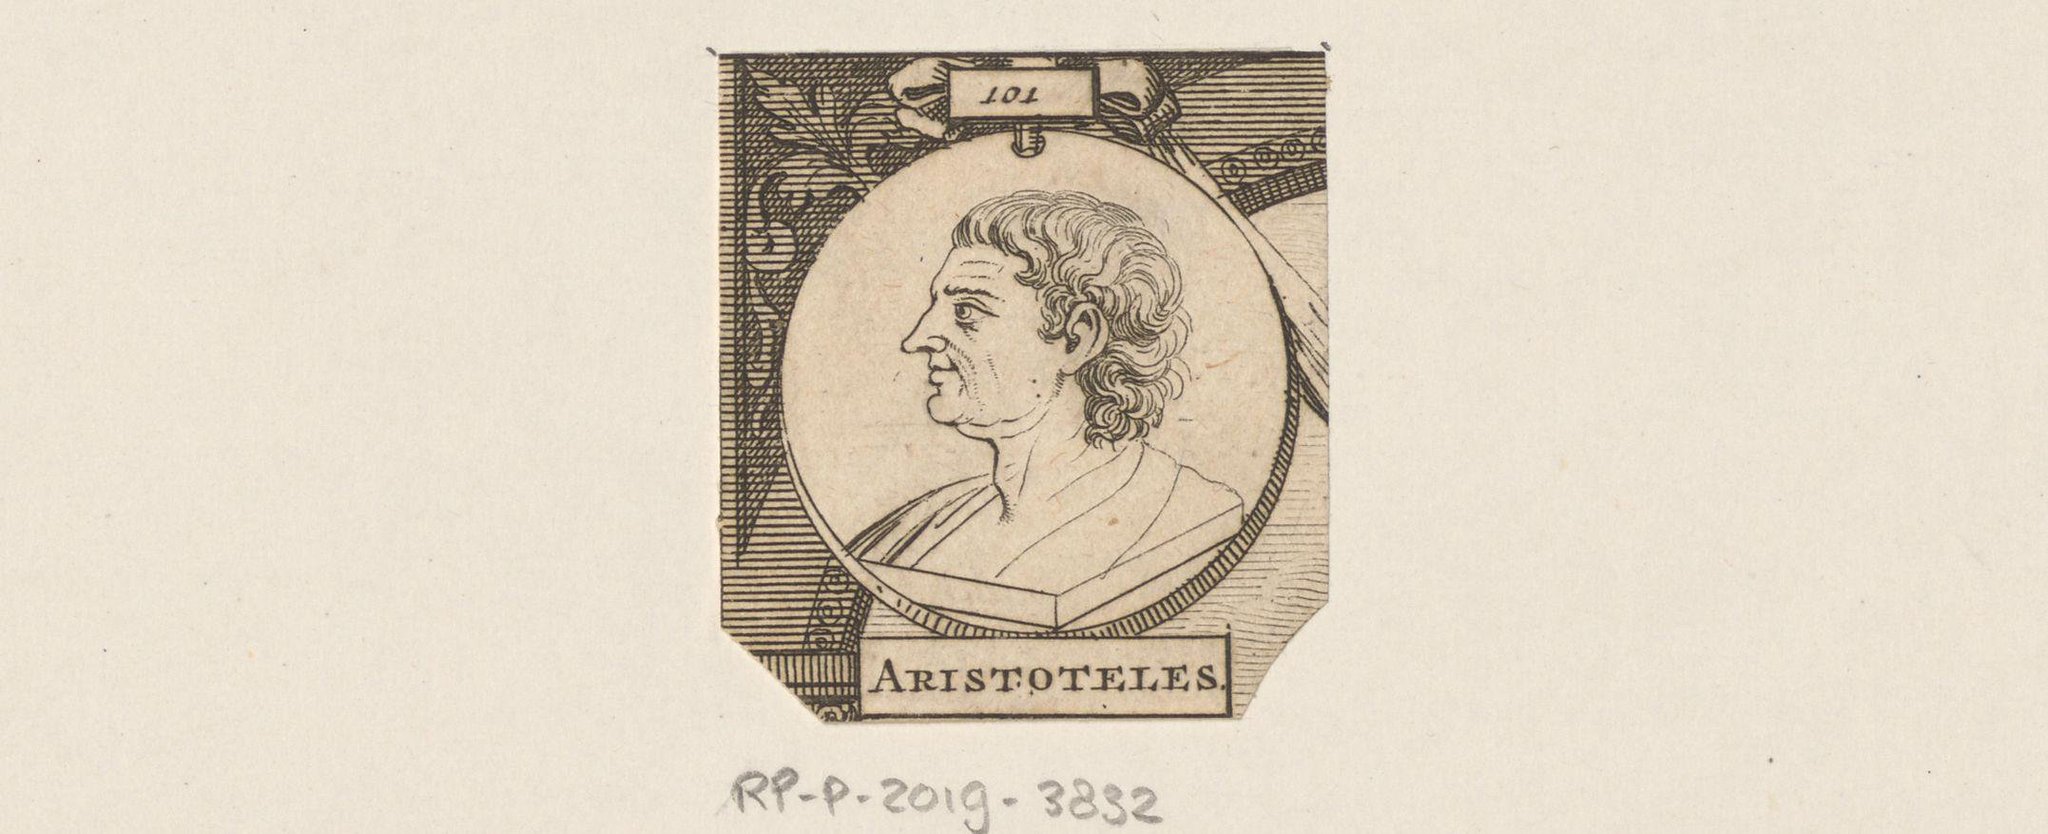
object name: print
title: Portret van Aristoteles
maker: Anonymous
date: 1650-1749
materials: paper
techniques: etching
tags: historical persons